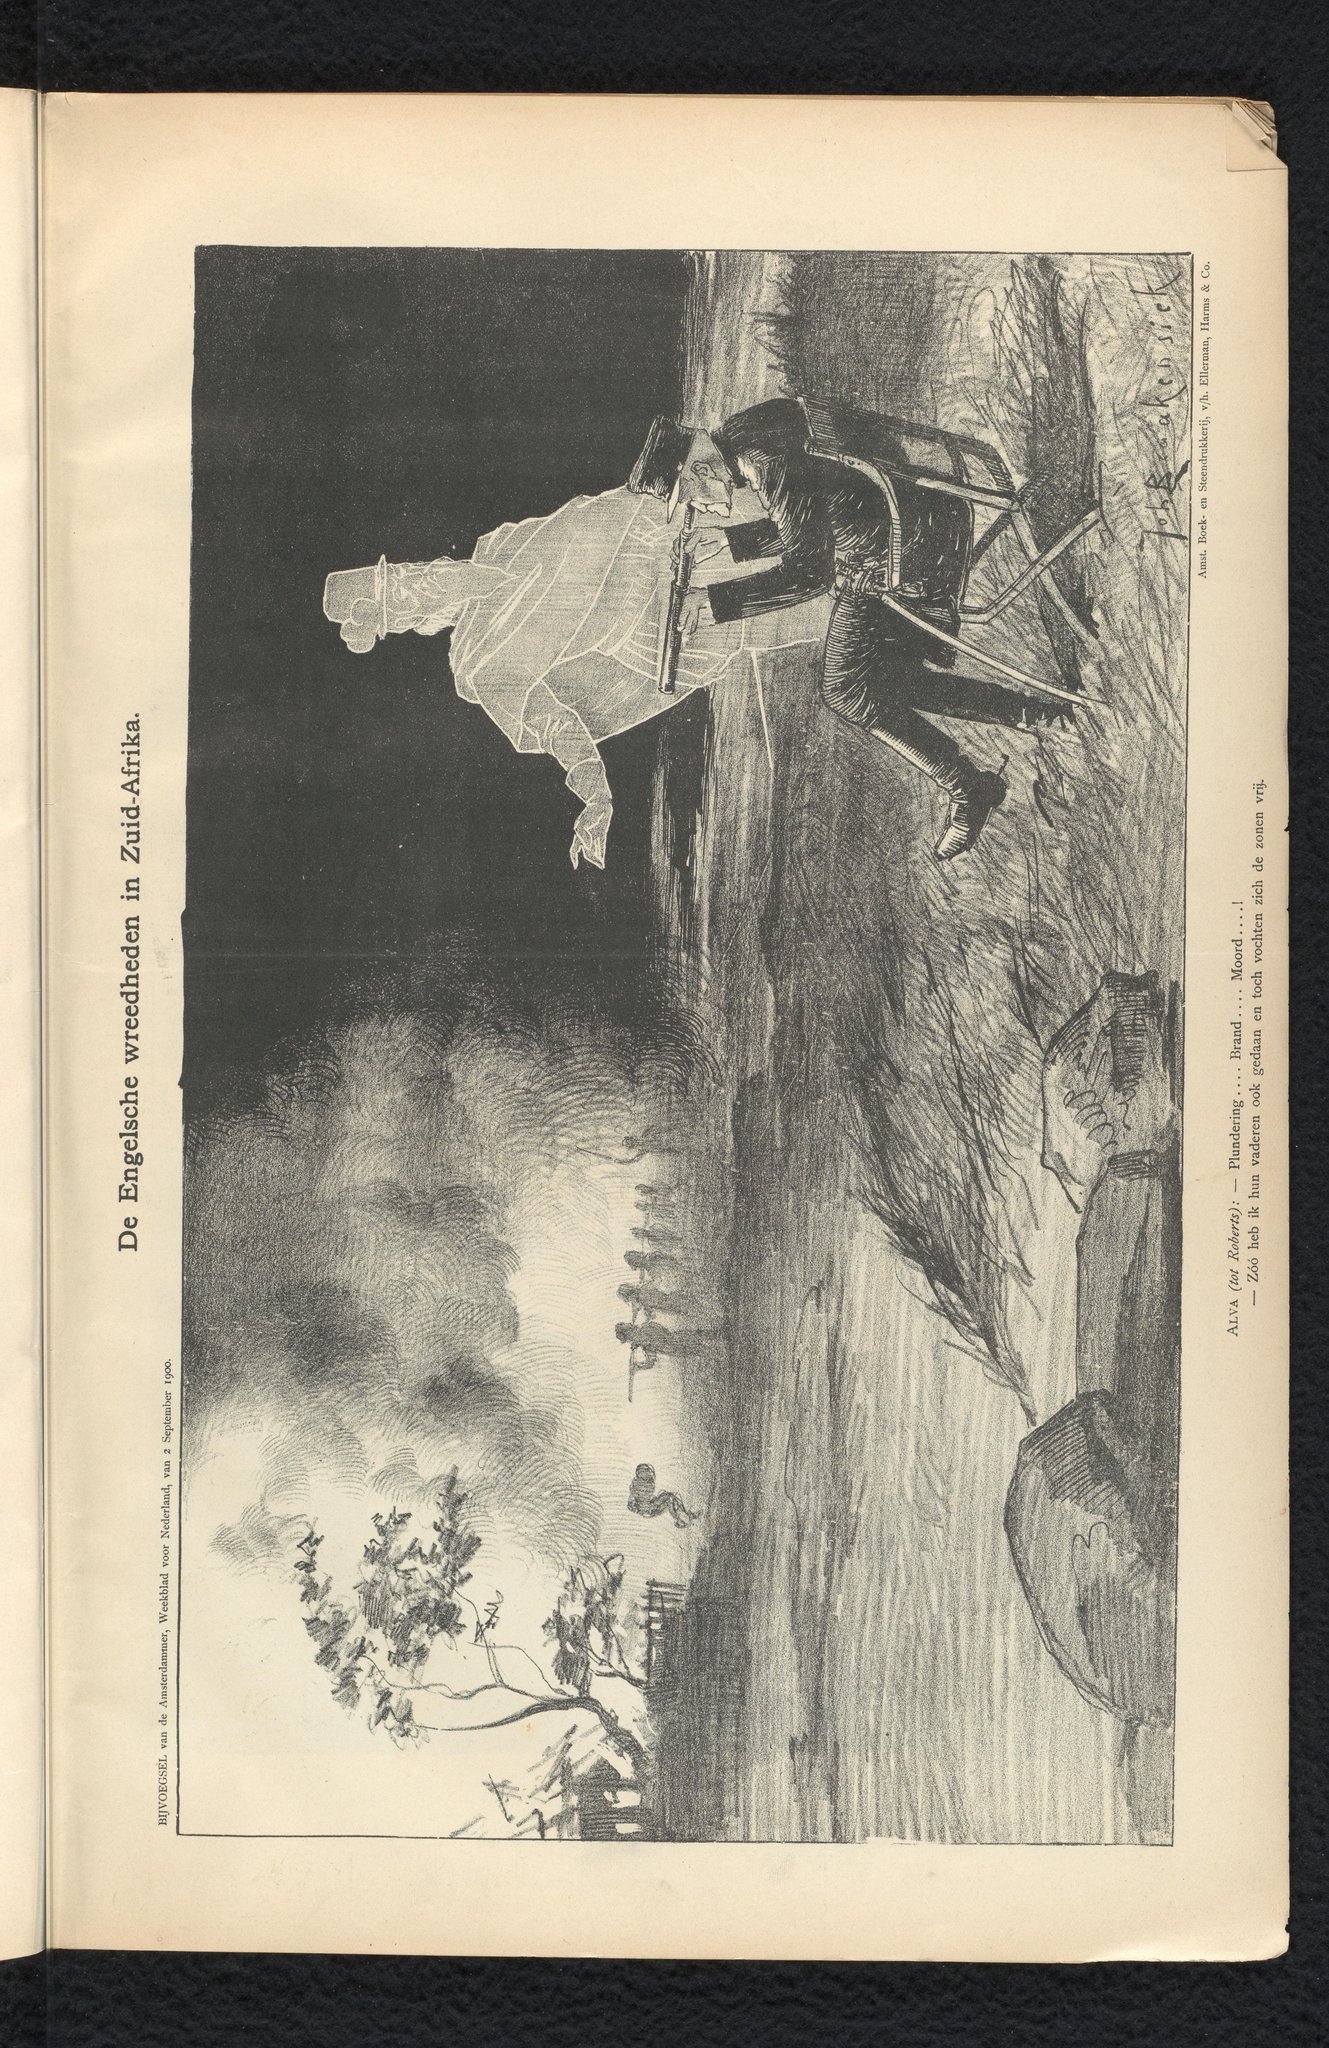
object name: cartoon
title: De Engelsche wreedheden in Zuid-Afrika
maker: johan braakensiek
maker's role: draughtsman, print maker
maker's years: 1858-1940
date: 1900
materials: paper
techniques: lithograph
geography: amsterdam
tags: fernando álvarez de toledo (3rd duke of alba), personifications of countries, nations, states, districts, etc., non-combatants ~ war, horrors of war, spirit, ghost, telescope, political caricatures and satires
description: De Engelse generaal Roberts bekijkt met een telescoop plundering, moord en brand door de Engelse troepen jegens de Boeren in Zuid-Afrika. De geest van de Hertog van Alva spreekt dat hij dit ook heeft gedaan met hun voorvaderen.